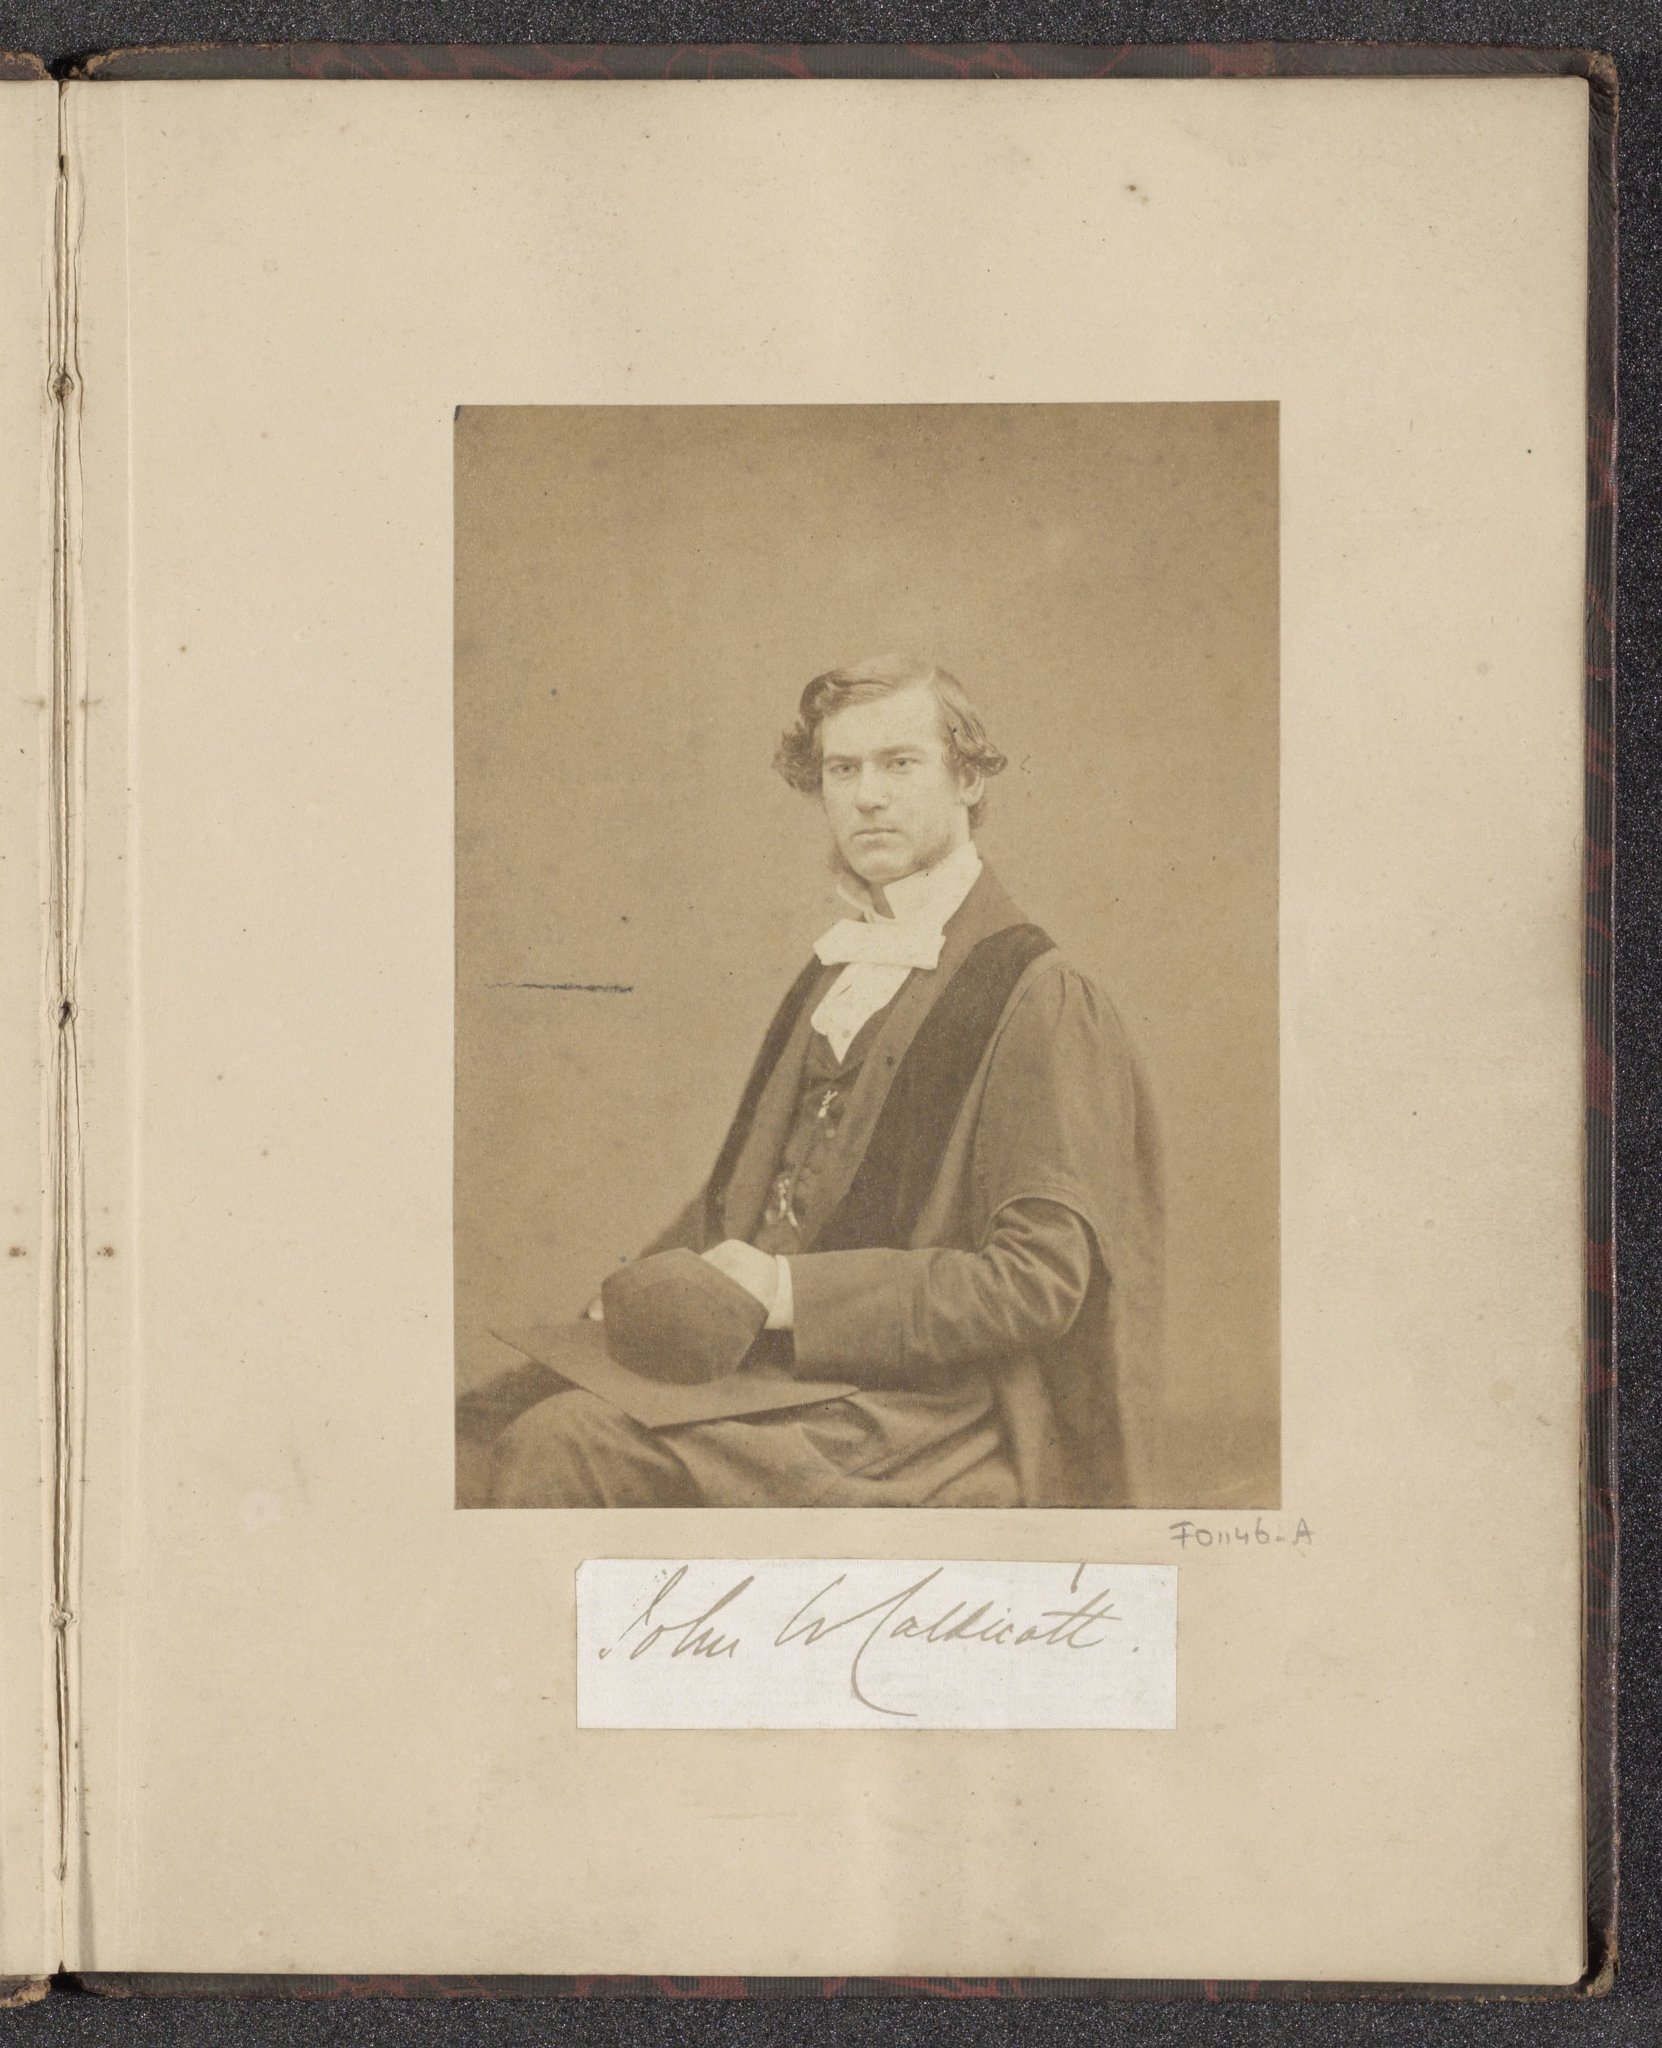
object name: photograph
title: Portret van John Waldicott, student in Oxford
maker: j. bagnall evans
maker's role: fotograaf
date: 1860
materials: paper, photographic support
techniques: albumen print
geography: oxford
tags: armchair, seat, sideburns, higher education, e.g.: teacher's college (+ pupil), university education, youth, adolescent, head-gear: hat (+ men's clothes), neck-gear ~ clothing, hairdress, dress, gown, student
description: Onderdeel van Fotoalbum met 6 portretten van studenten van het Jesus College in Oxford.